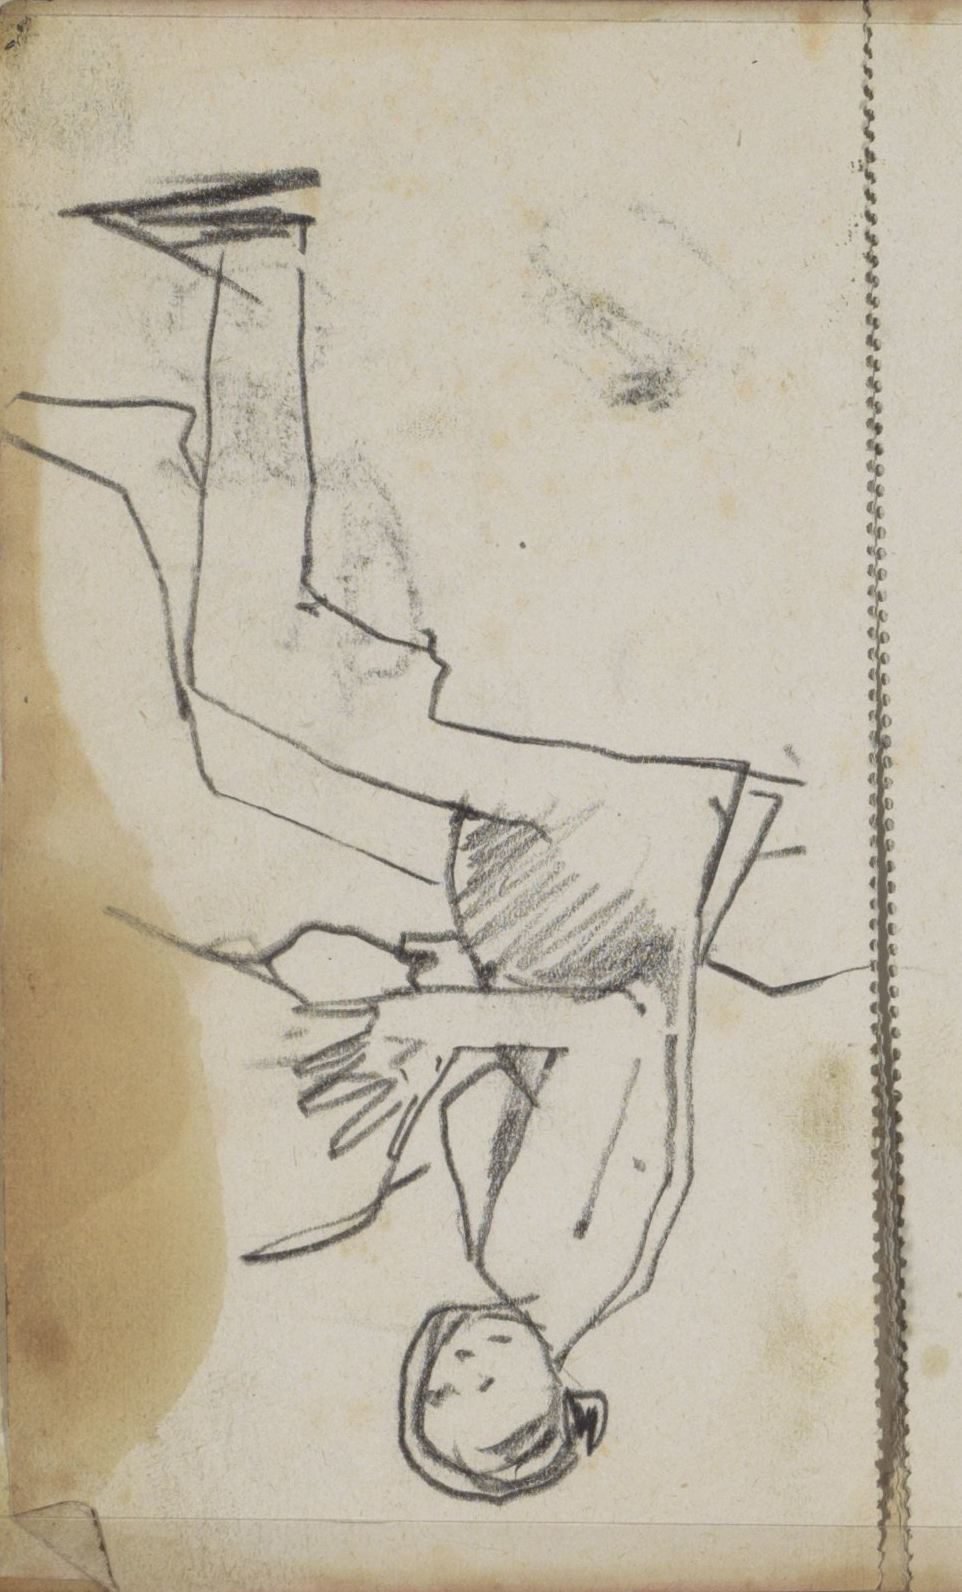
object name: sketchbook leaf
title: Zittende vrouw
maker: george hendrik breitner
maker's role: draughtsman, painter, print maker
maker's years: 1857-1923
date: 1893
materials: chalk, paper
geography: amsterdam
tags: sitting figure - aa - female human figure, the (nude) human figure; 'corpo humano' (ripa) - aa - female human figure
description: Zittende vrouw, mogelijk naakt, met een voorwerp in haar handen. Pagina 5 uit een schetsboek met 22 bladen vervaardigd te Amsterdam.